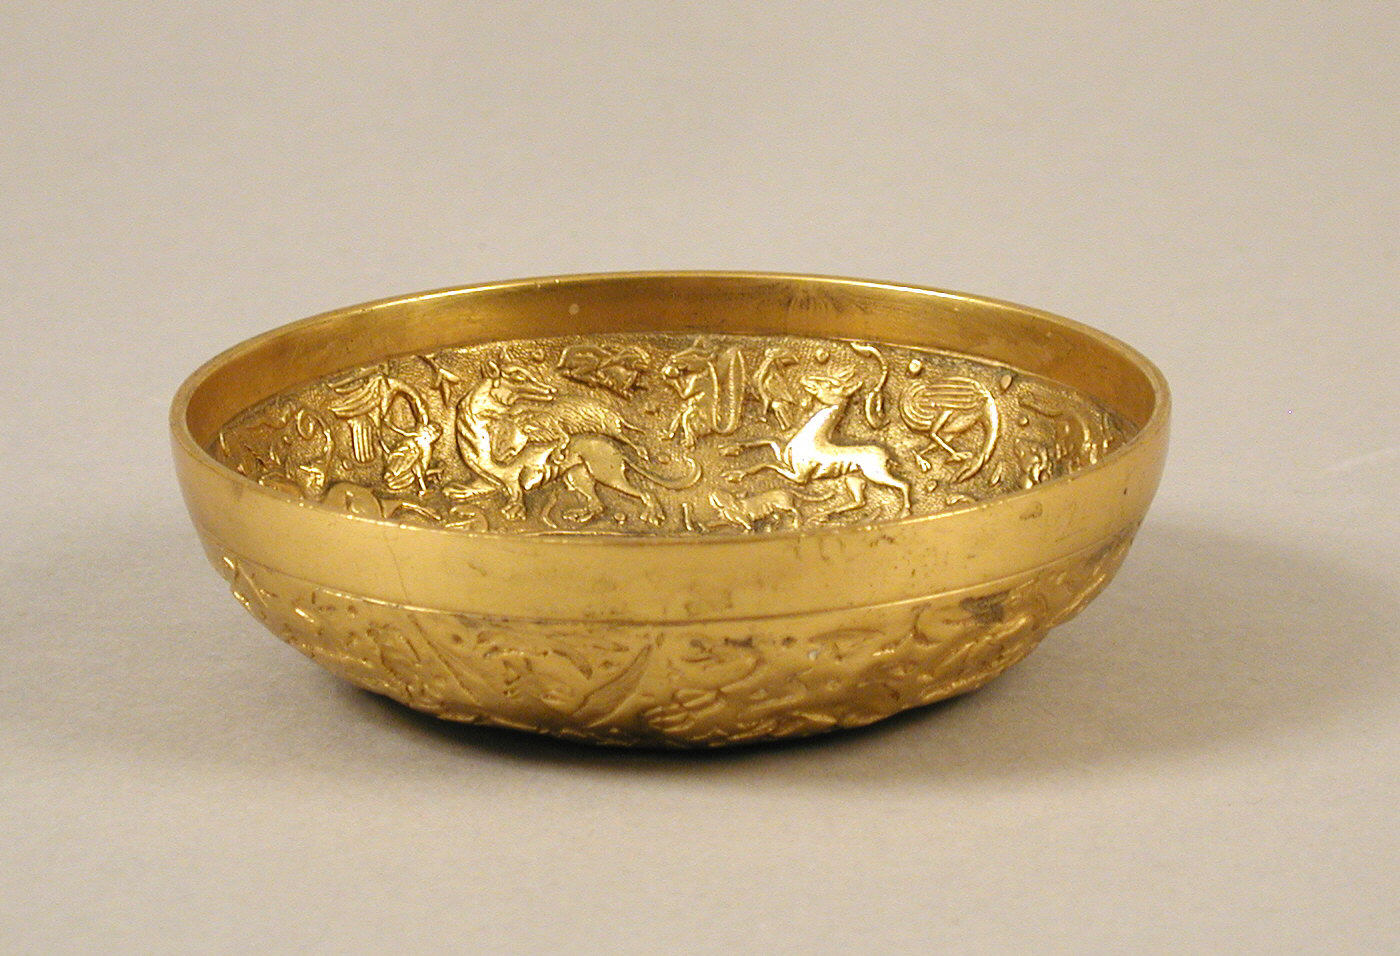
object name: bowl or cup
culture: byzantine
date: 1801-1900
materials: gold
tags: animals